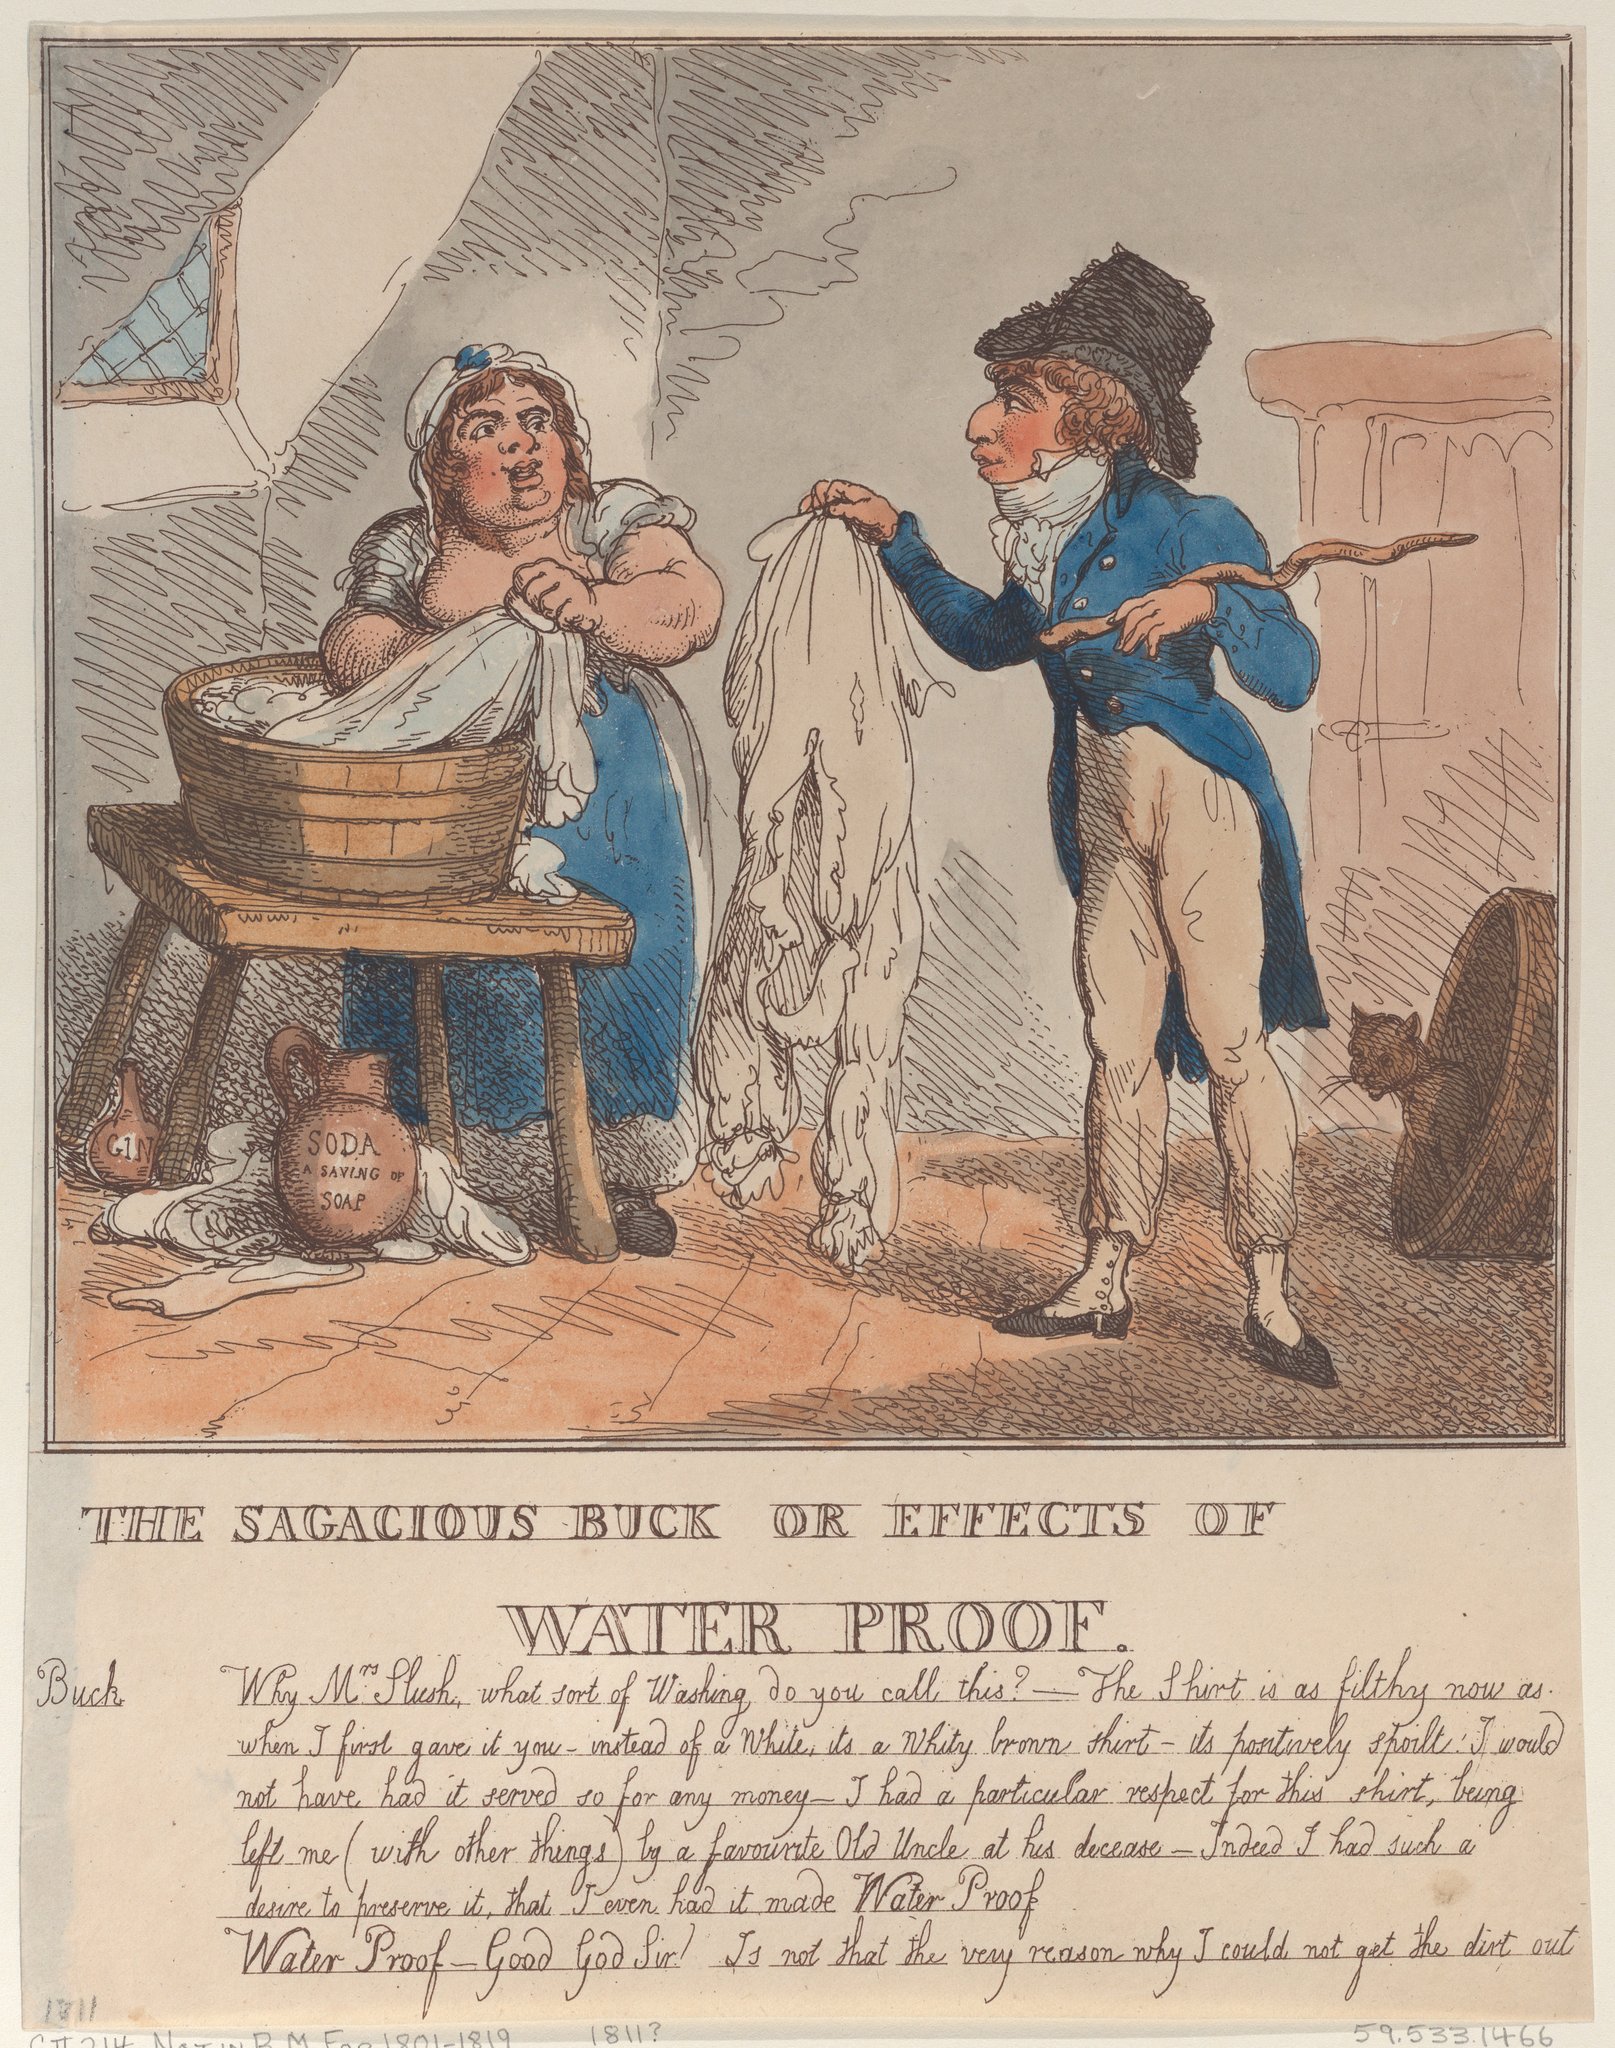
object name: print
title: The Sagacious Buck or Effects of Water Proof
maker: thomas rowlandson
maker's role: artist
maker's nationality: british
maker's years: 1757-1827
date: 1811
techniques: etching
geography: london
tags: satire,men,women,washing